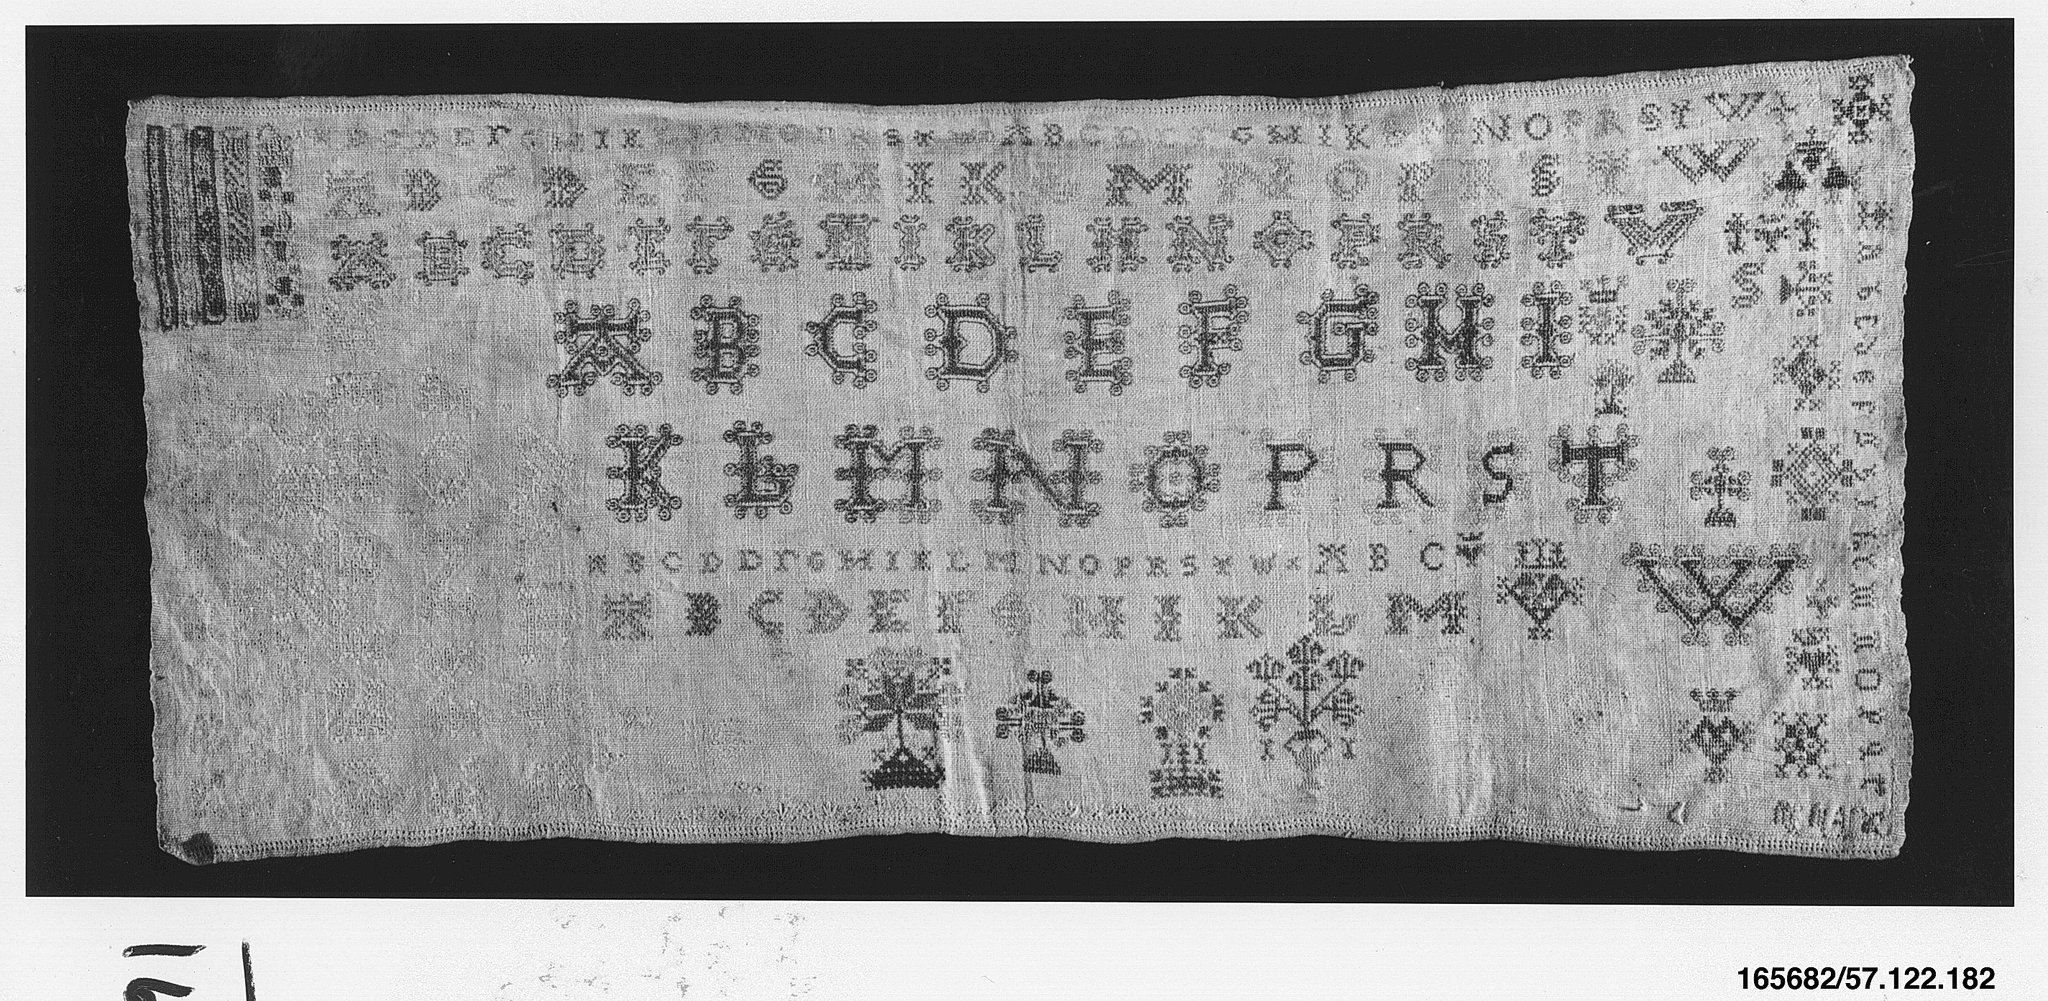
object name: sampler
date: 1701-1800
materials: linen, silk